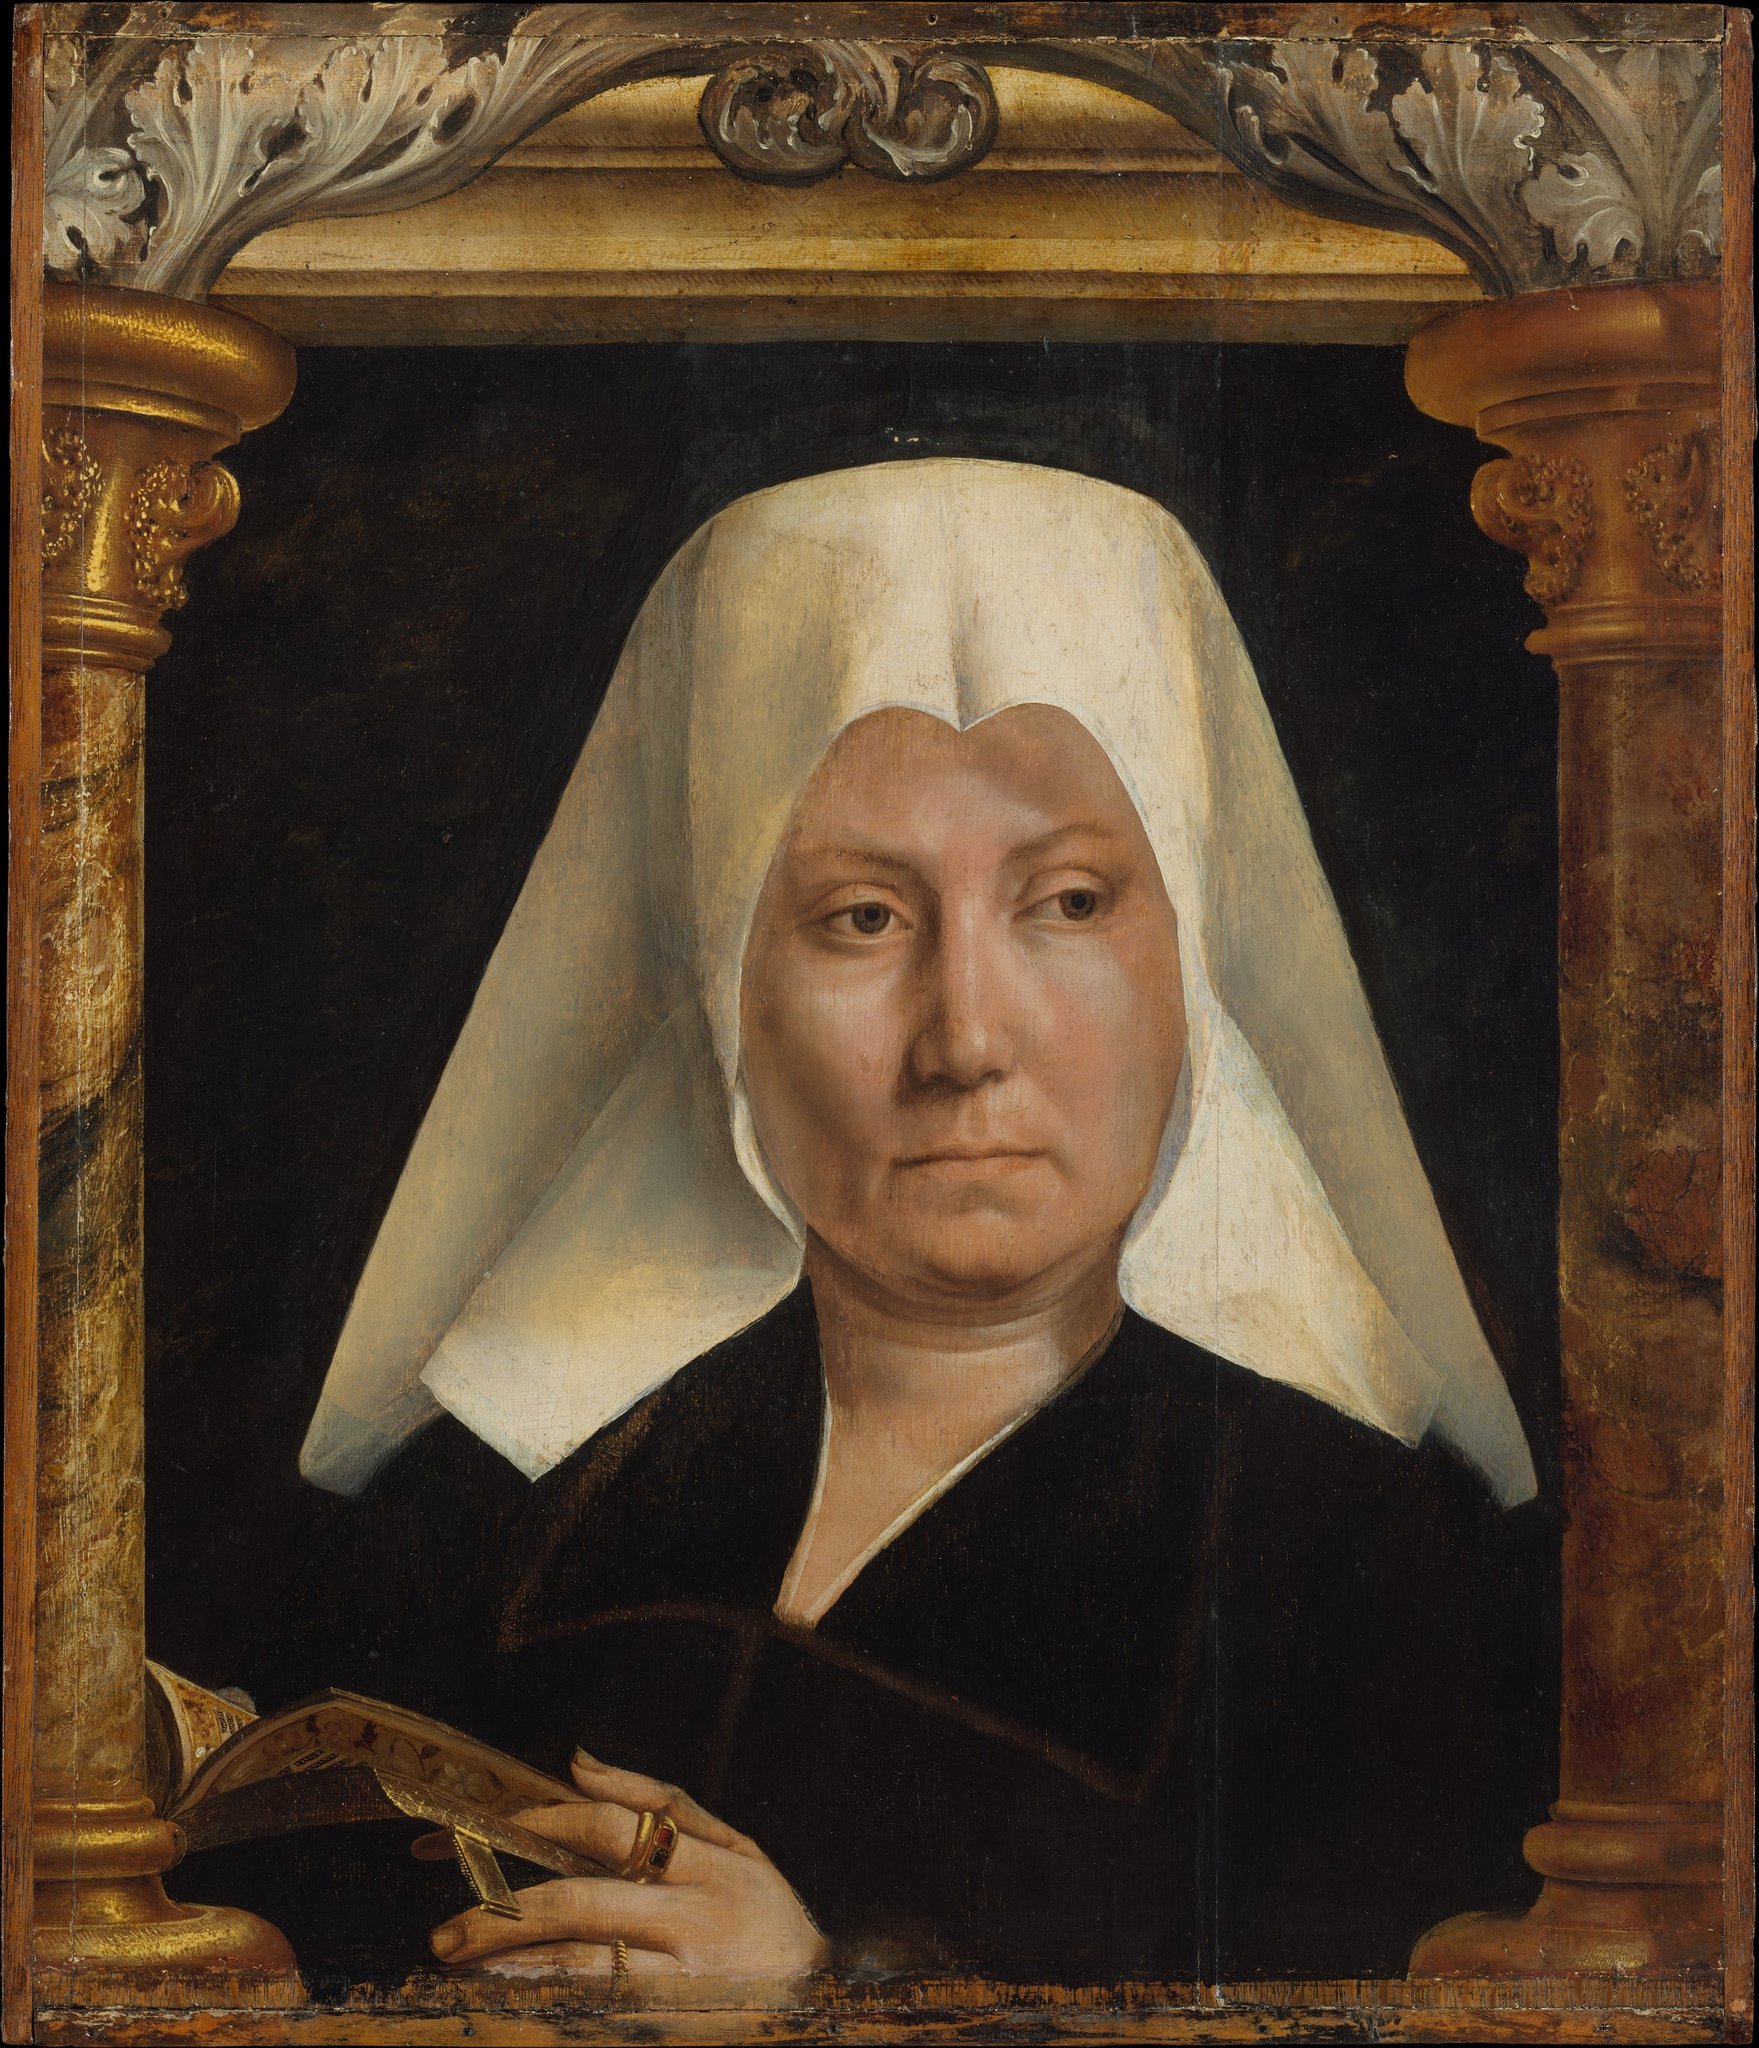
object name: painting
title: Portrait of a Woman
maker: quinten massys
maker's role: artist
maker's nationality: netherlandish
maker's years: 1466-1530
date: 1520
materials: oil, wood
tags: books,portraits,women